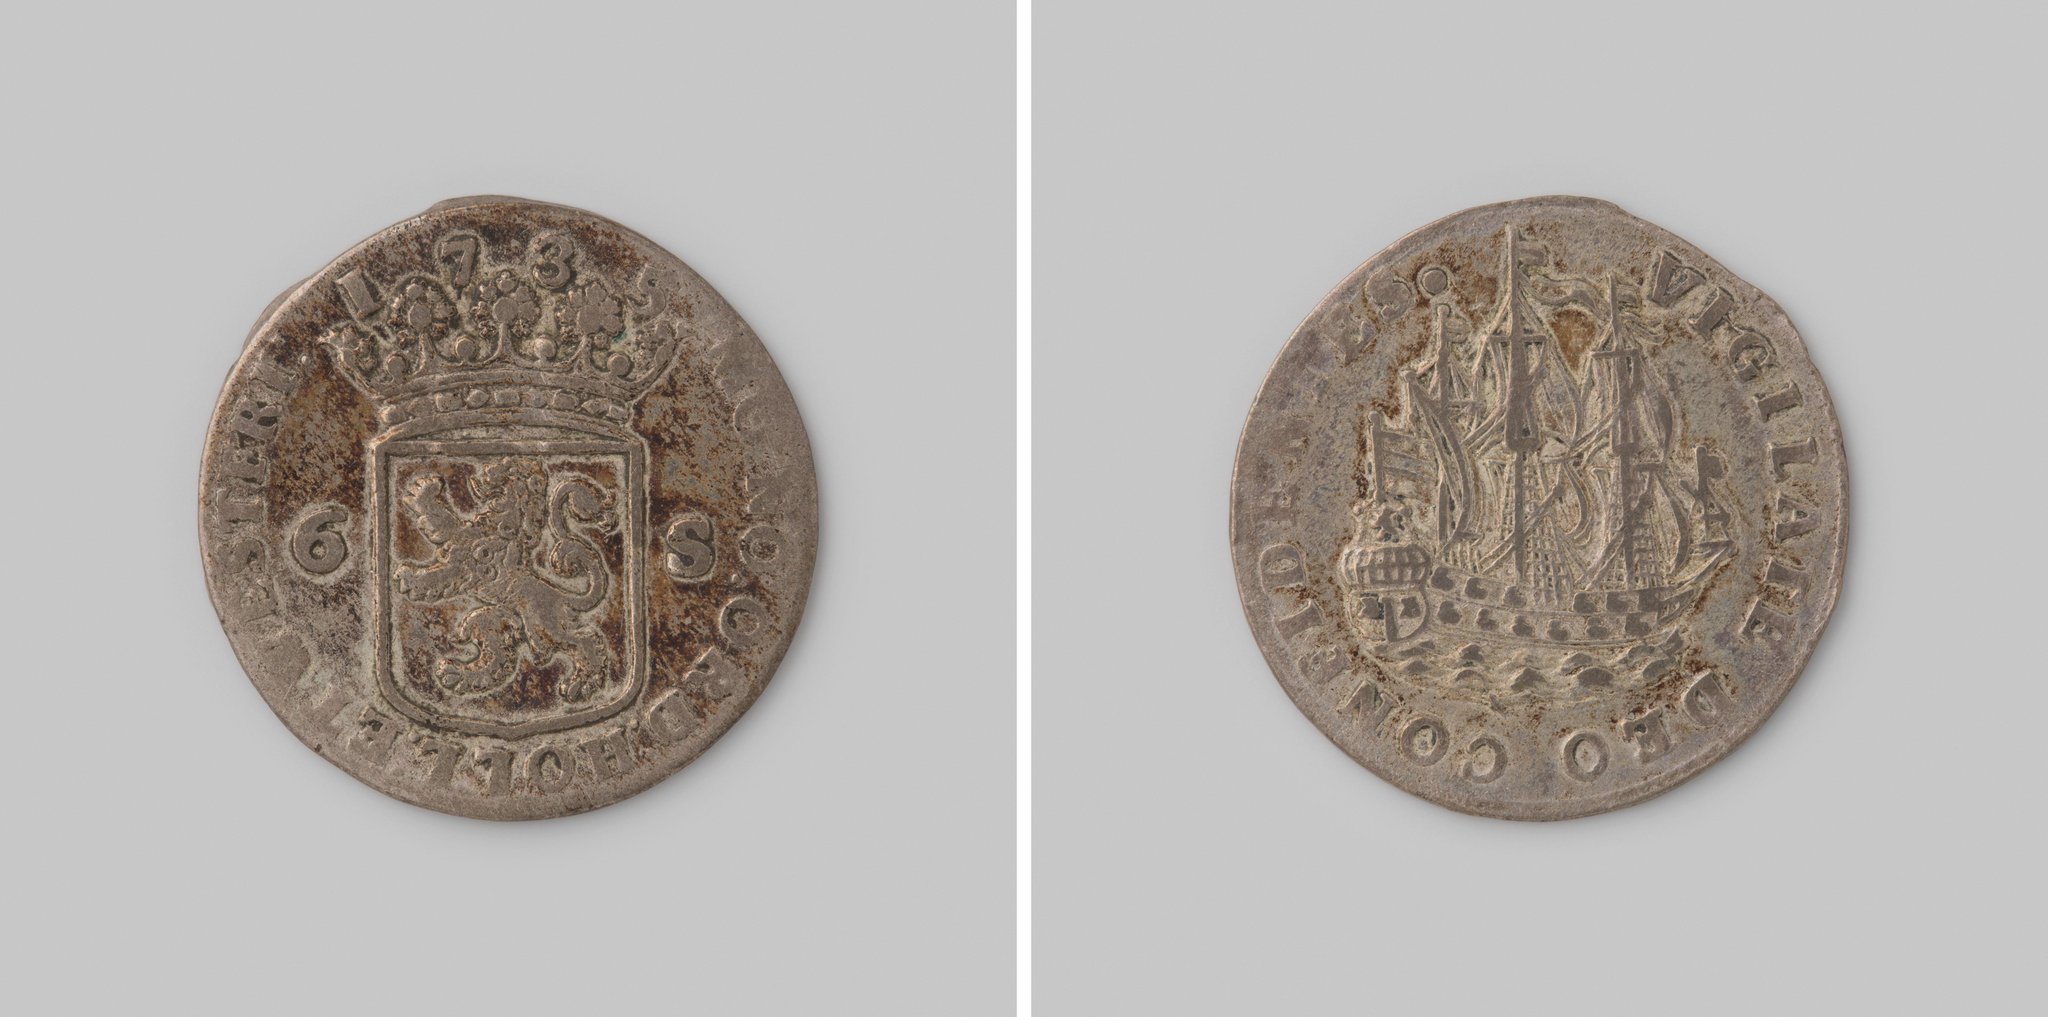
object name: coin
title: Hollandse scheepjesschelling, 1735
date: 1735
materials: silver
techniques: striking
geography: dordrecht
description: Zilveren munt. Voorzijde: tussen waarde-aanduiding 6 S gekroond wapenschild van Holland. Jaartal boven kroon. Keerzijde: oorlogsschip, varend naar rechts.